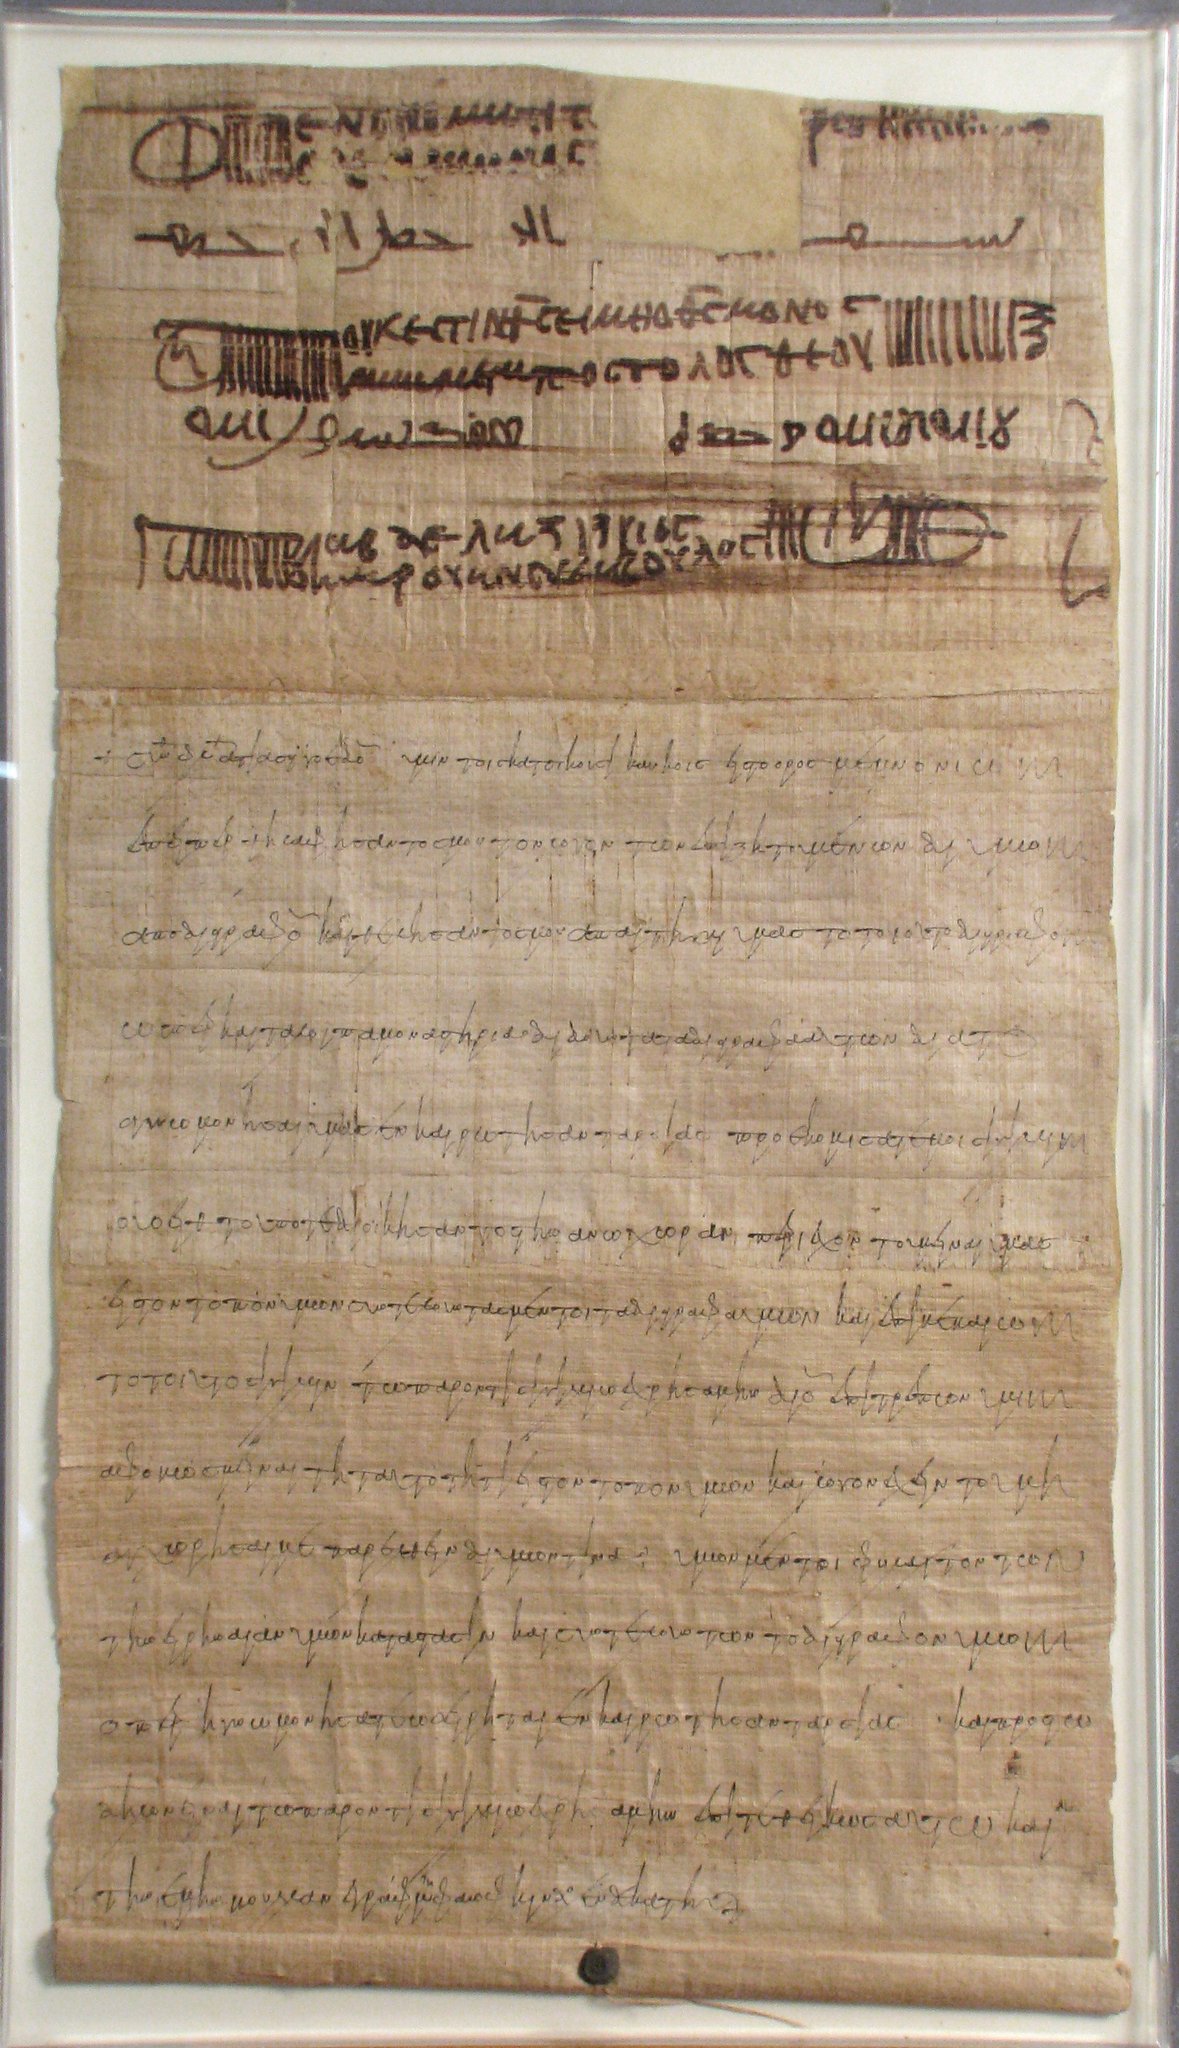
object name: papyrus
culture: coptic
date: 698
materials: ink, papyrus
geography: egypt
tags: coptic,documents,greek